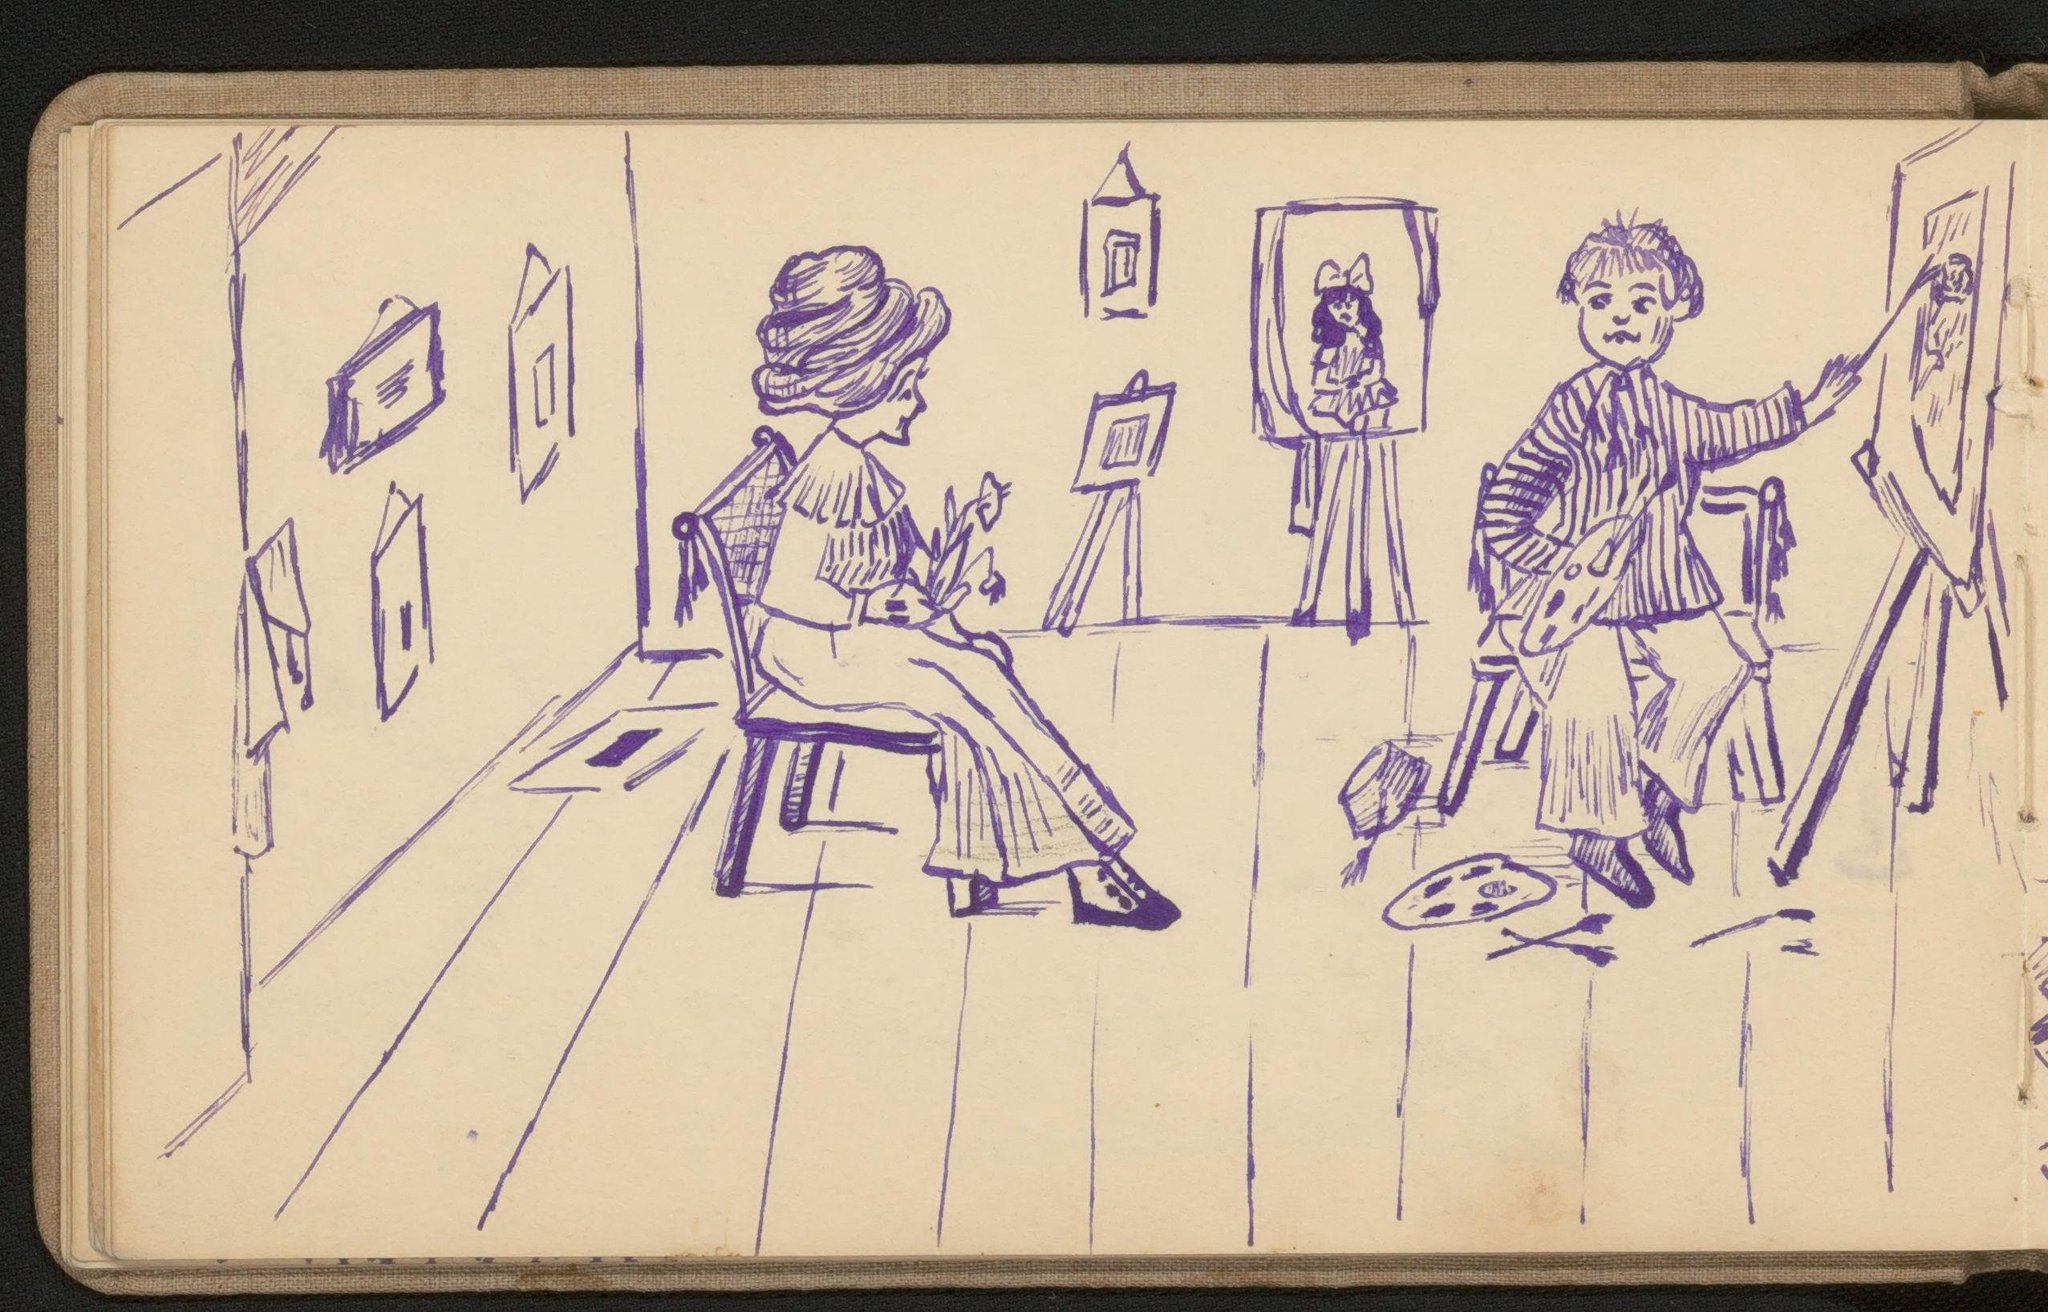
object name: sketchbook leaf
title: Moeder laat zich portretteren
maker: Anonymous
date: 1875-1920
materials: ink, paper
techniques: pen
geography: netherlands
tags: family life at home, painter working from clothed model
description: Moeder laat zich portretteren door een schilder. Onderdeel van het schetsboek met humoristische tekeningen over het leven van een 'famille nombreuse'. Onderwerpsrubrieken binnen de Atlas Zeden en Gewoonten: Zeden en Gewoonten in Engeren Zin, Des menschen beging, midden en einde, Kinderleven.